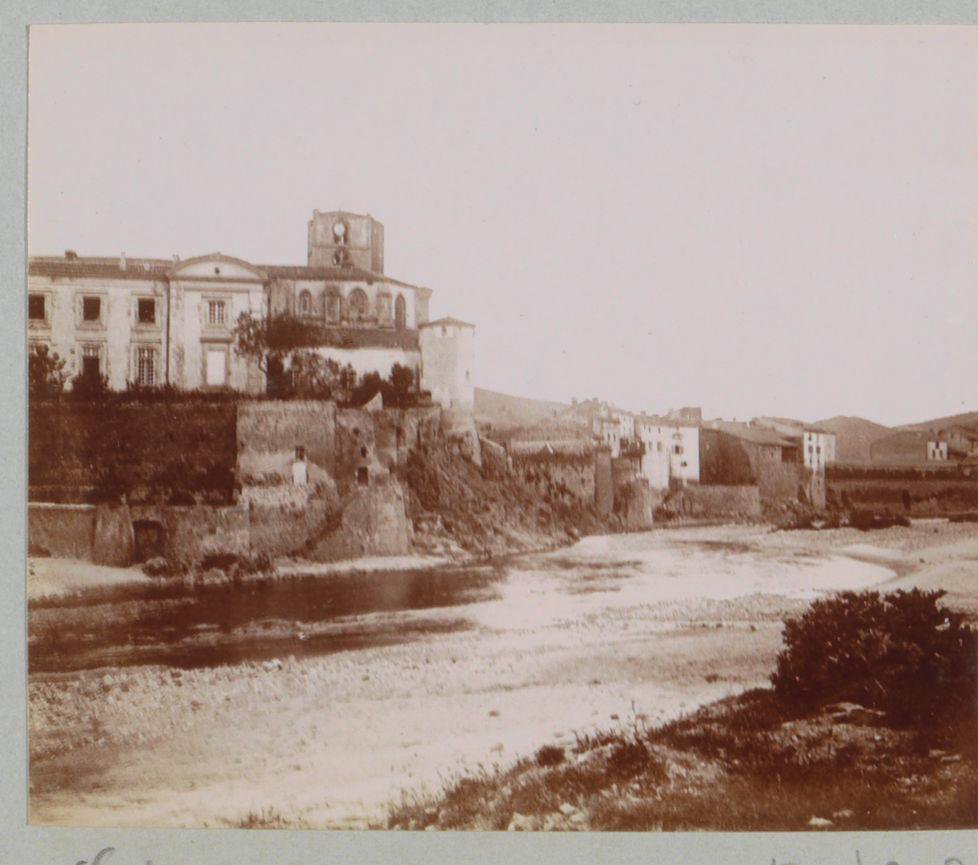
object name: photograph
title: Gezicht op Lavoûte-Chilhac aan de Allier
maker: delizy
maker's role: manufacturer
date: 1902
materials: paper, photographic support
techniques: gelatin silver print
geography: saint-ilpize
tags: prospect of village, silhouette of village, river (+ landscape with figures, staffage)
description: Onderdeel van Fotoalbum van een Franse amateurfotograaf met opnames van uitstapjes in Frankrijk, Spanje, België, Luxemburg en Nederland, de eerste automobielen en autoraces.